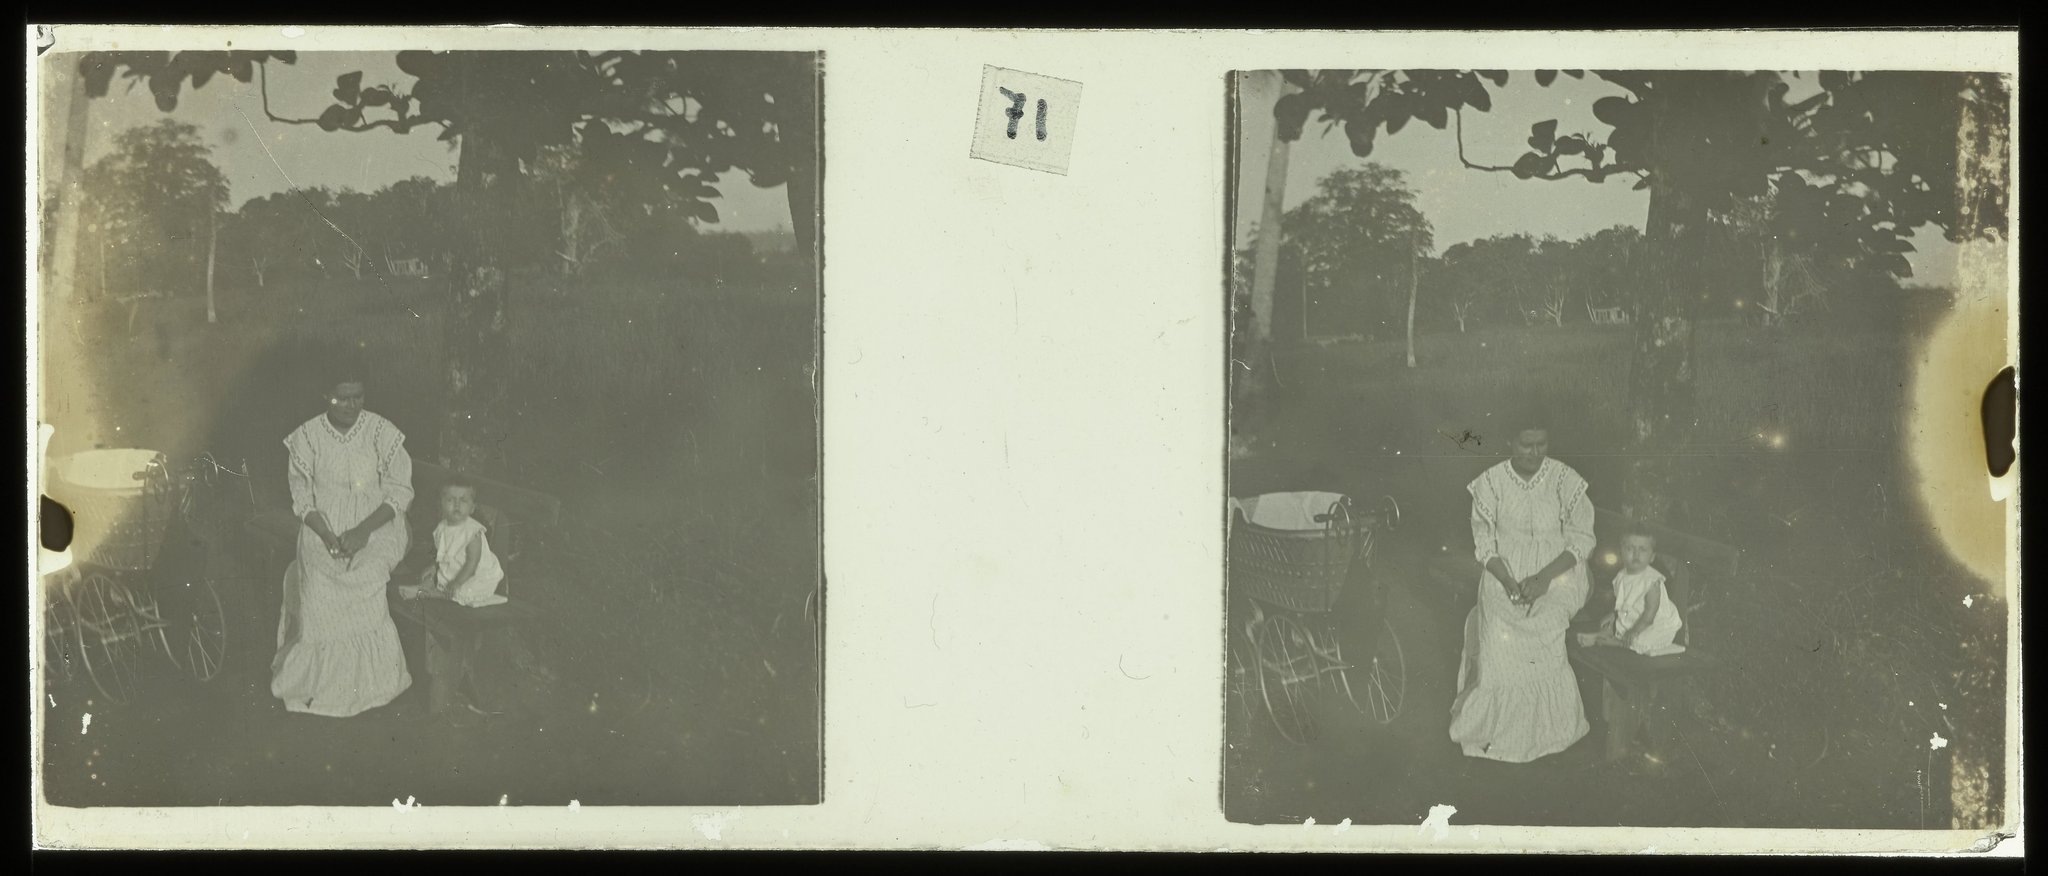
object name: stereograph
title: Plantage Accaribo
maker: theodoor brouwers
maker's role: amateurfotograaf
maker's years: 1874-1932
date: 1913-1930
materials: glass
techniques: photography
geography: suriname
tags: theodoor brouwers, plantation, suriname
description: In de periode 1911-1932 woonde op plantage Accaribo in Suriname de familie Brouwers van wie de foto's afkomstig zijn. Rond 1910 vond Theodoor Brouwers werk op plantage Accaribo. In 1929 werd hij eigenaar van de plantage. Op Accaribo werden in zijn tijd bananen geproduceerd en wat koffie.